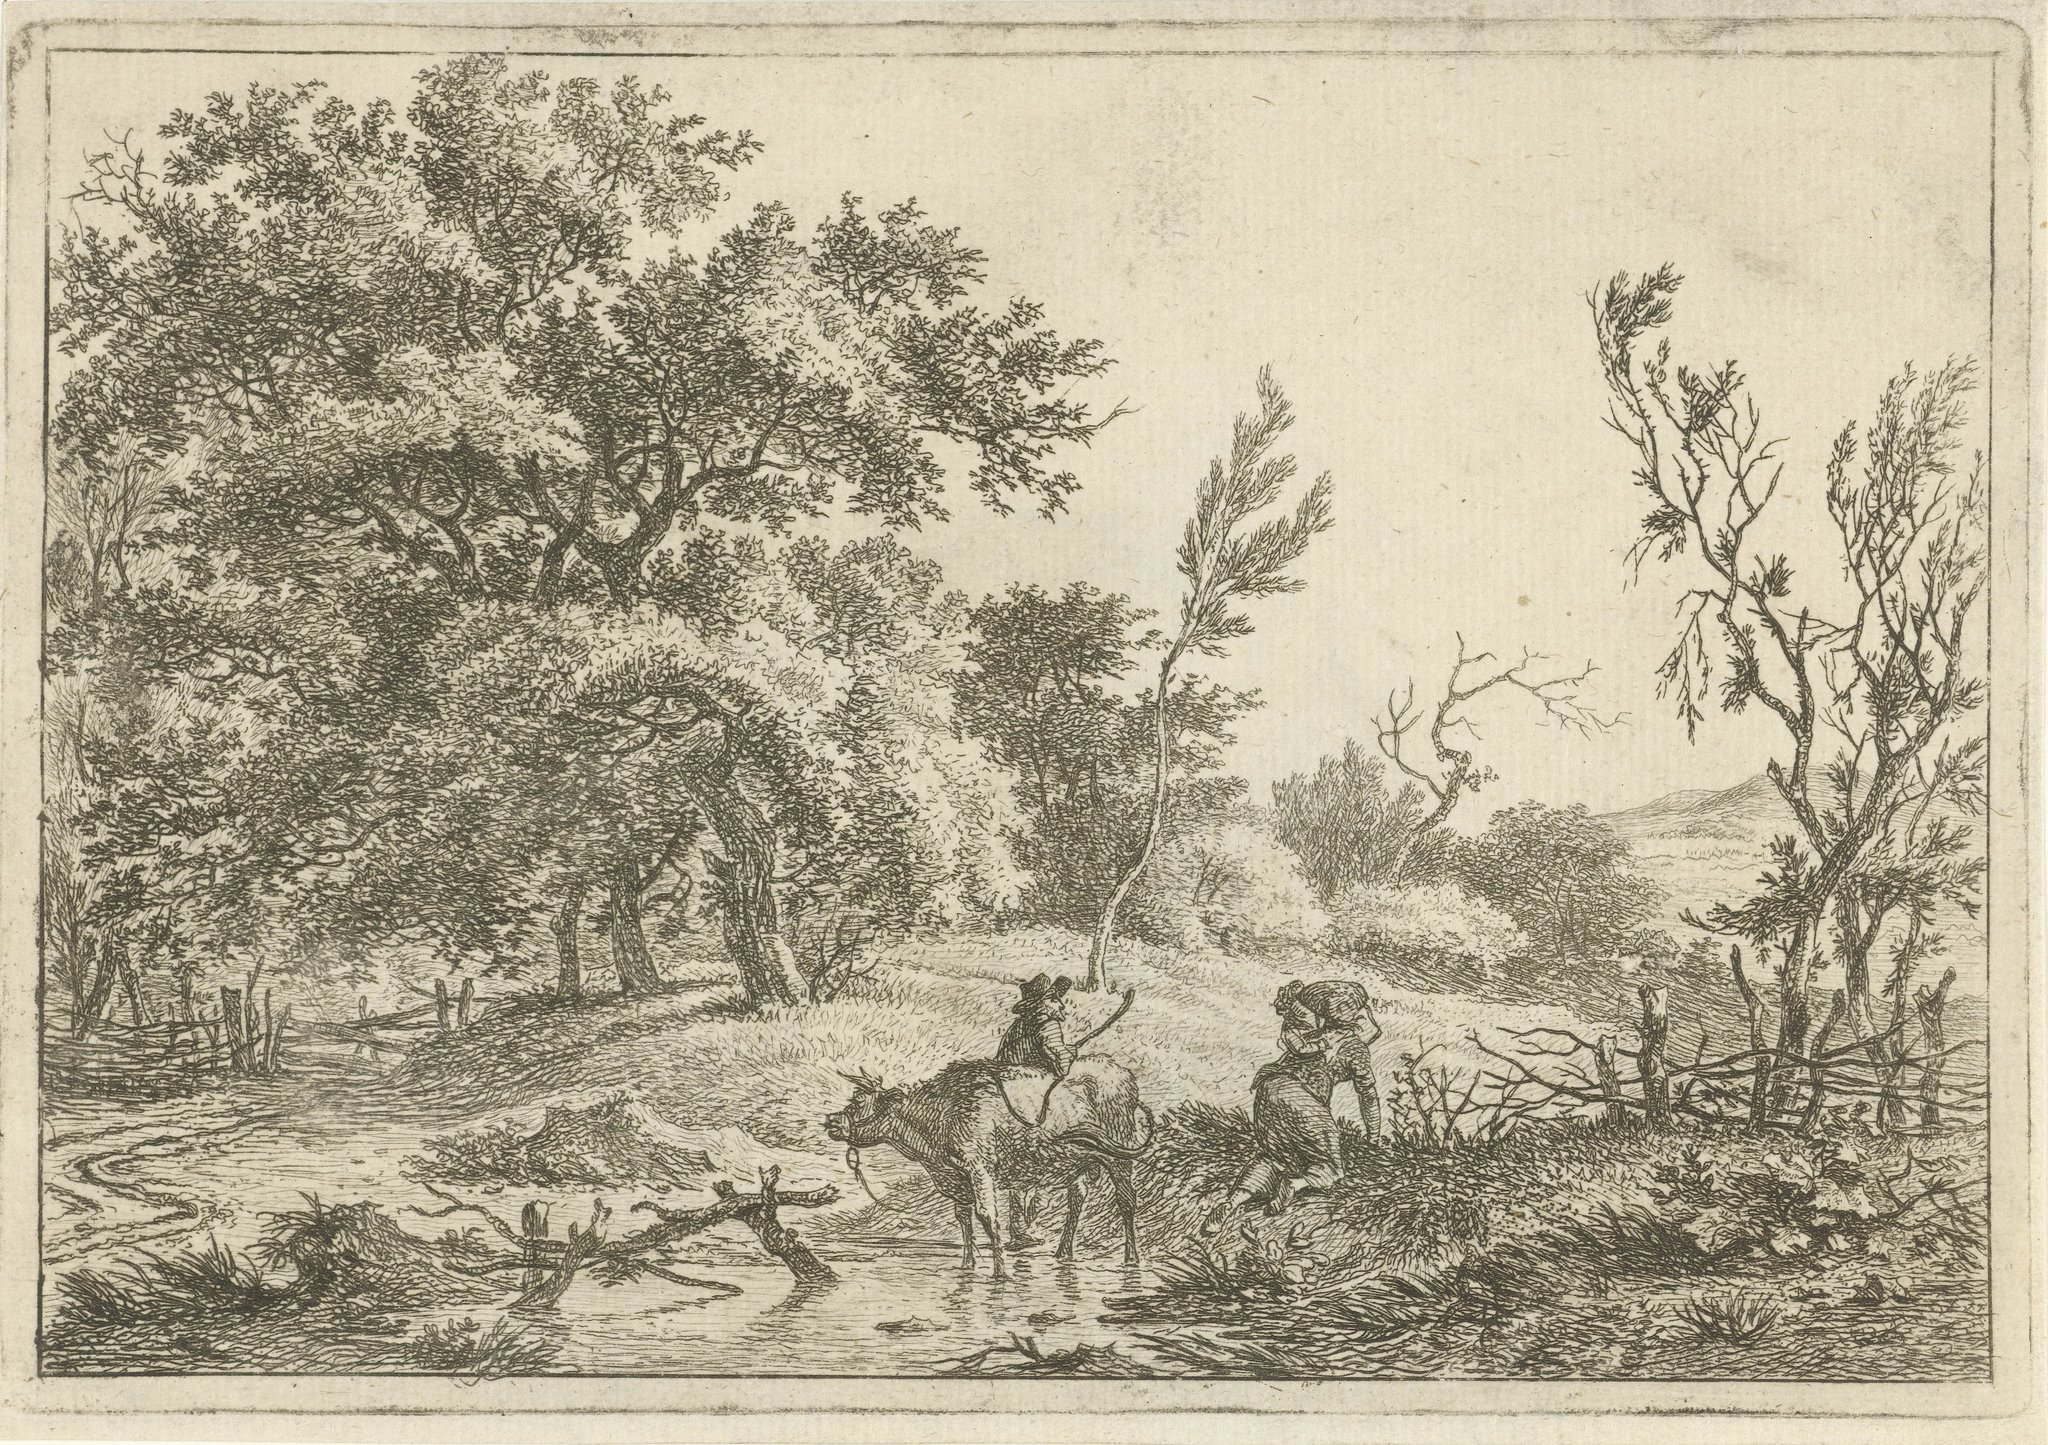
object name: print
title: Landschap met stier en veehoeder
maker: hermanus fock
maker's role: conservator, draughtsman, painter, print maker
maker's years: 1766-1822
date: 1781-1822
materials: paper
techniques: etching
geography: amsterdam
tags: bull, forest, wood (+ landscape with figures, staffage)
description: In een glooiend landschap staat een stier in ondiep water. Achter de stier staat een veehoeder en in het gras zitten een man en een vrouw. Op de achtergrond leidt een slingerend pad het bos in.